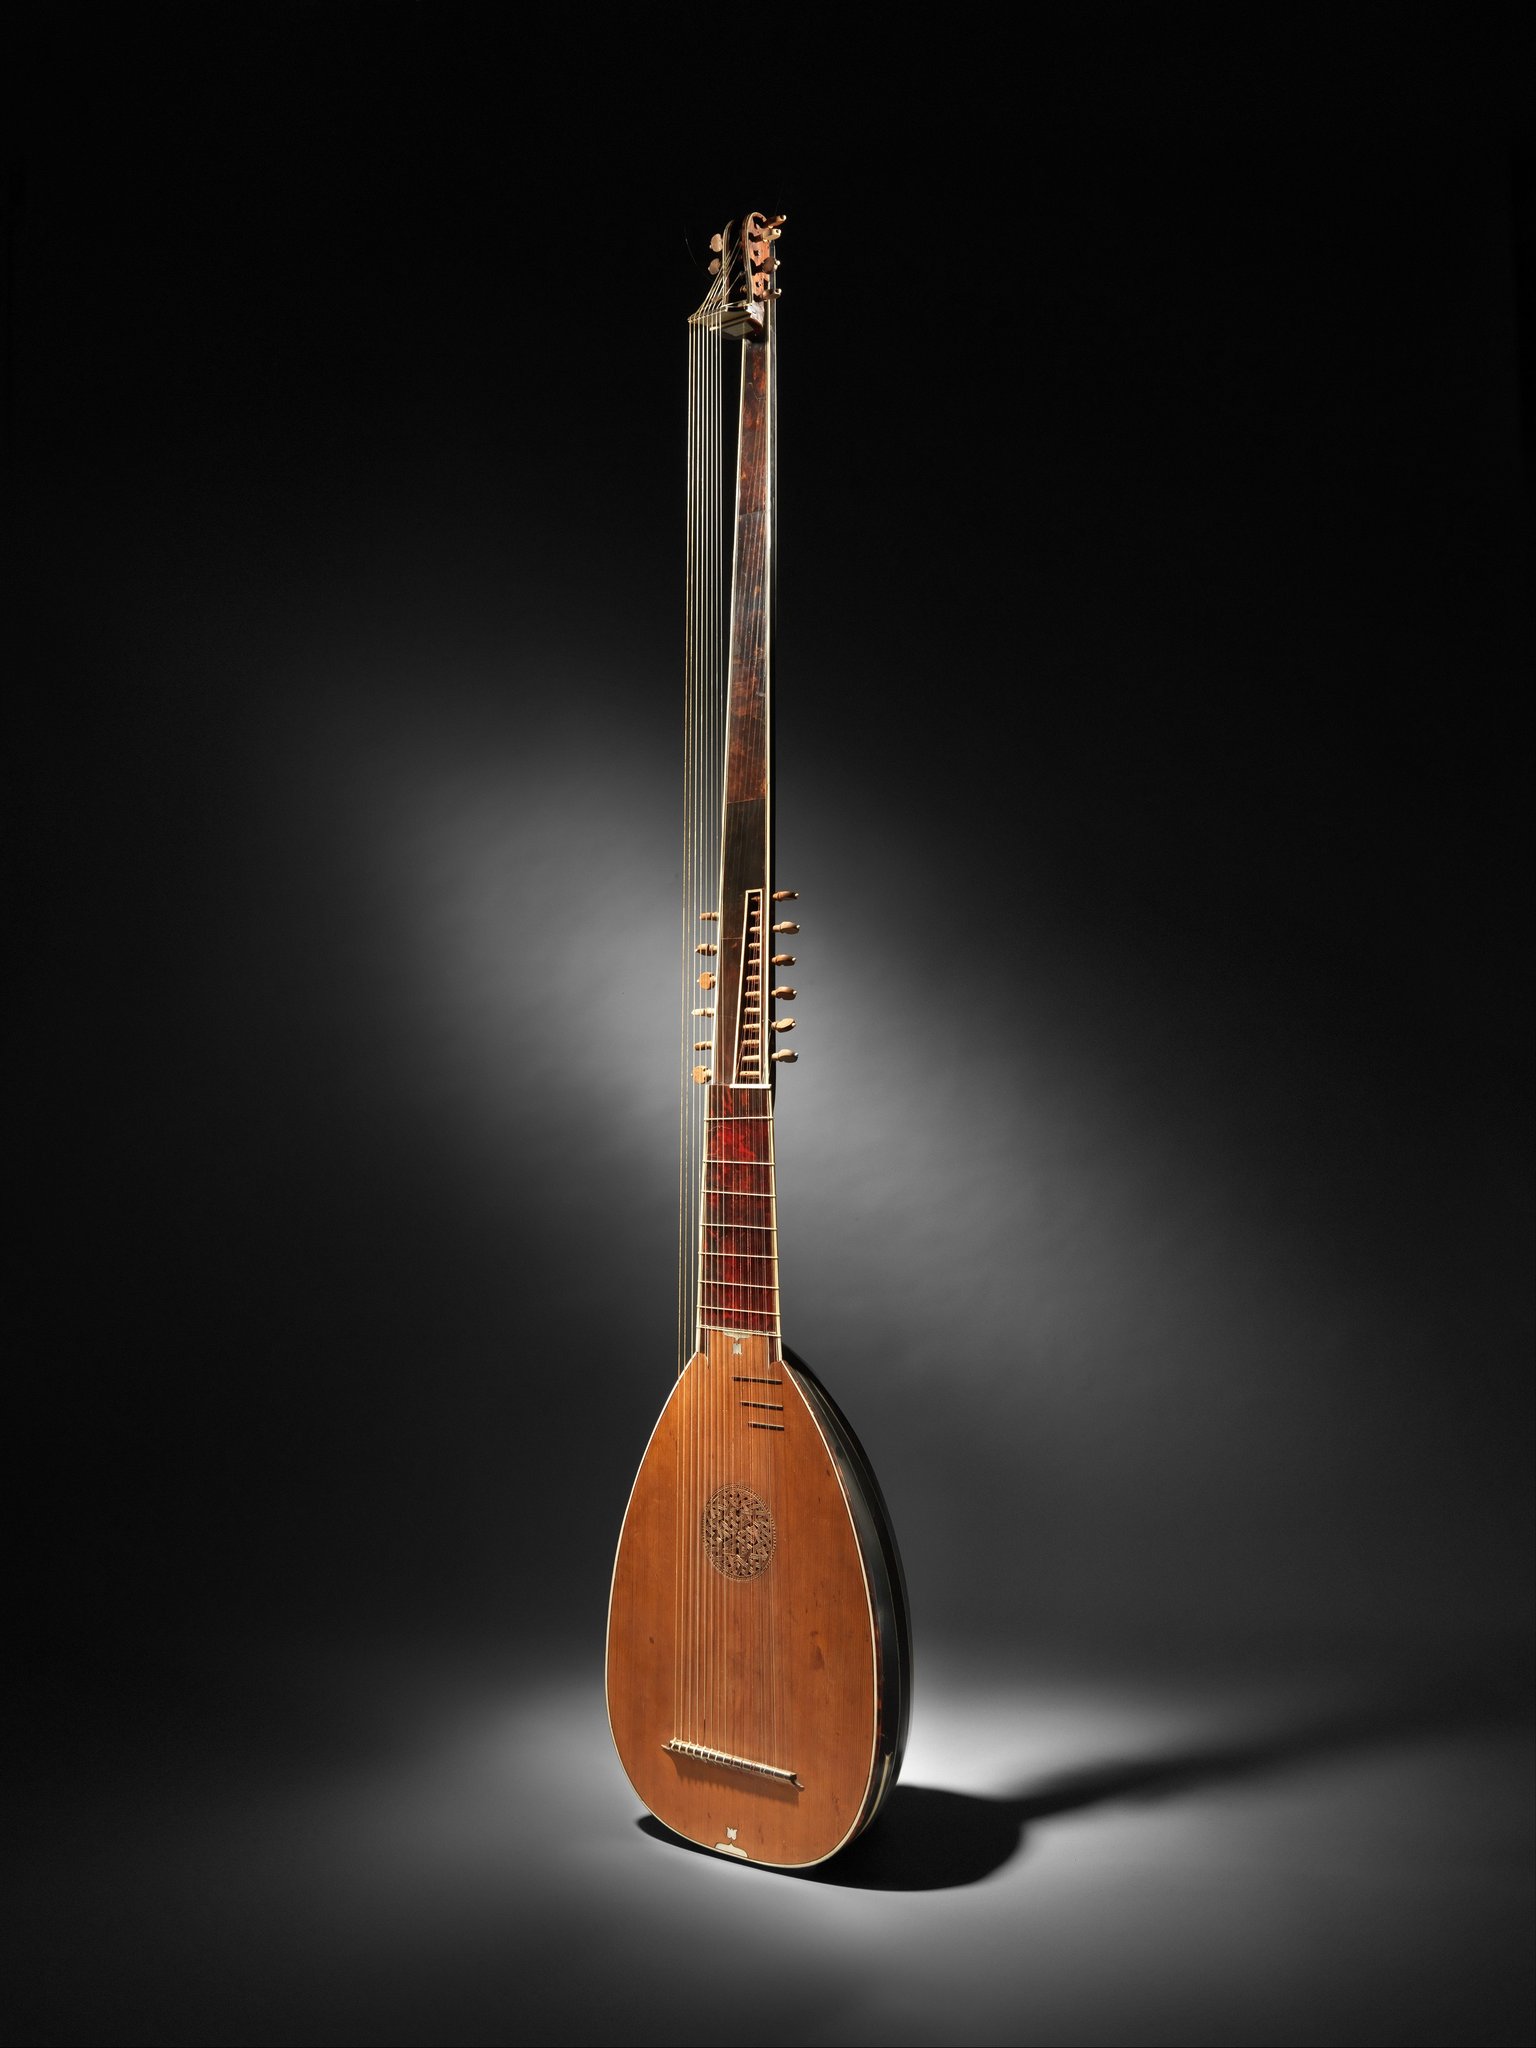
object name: archlute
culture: italian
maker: david tecchler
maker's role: maker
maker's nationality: austrian, active italy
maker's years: 1666-1747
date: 1725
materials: wood, ivory, mother of pearl, shell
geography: italy